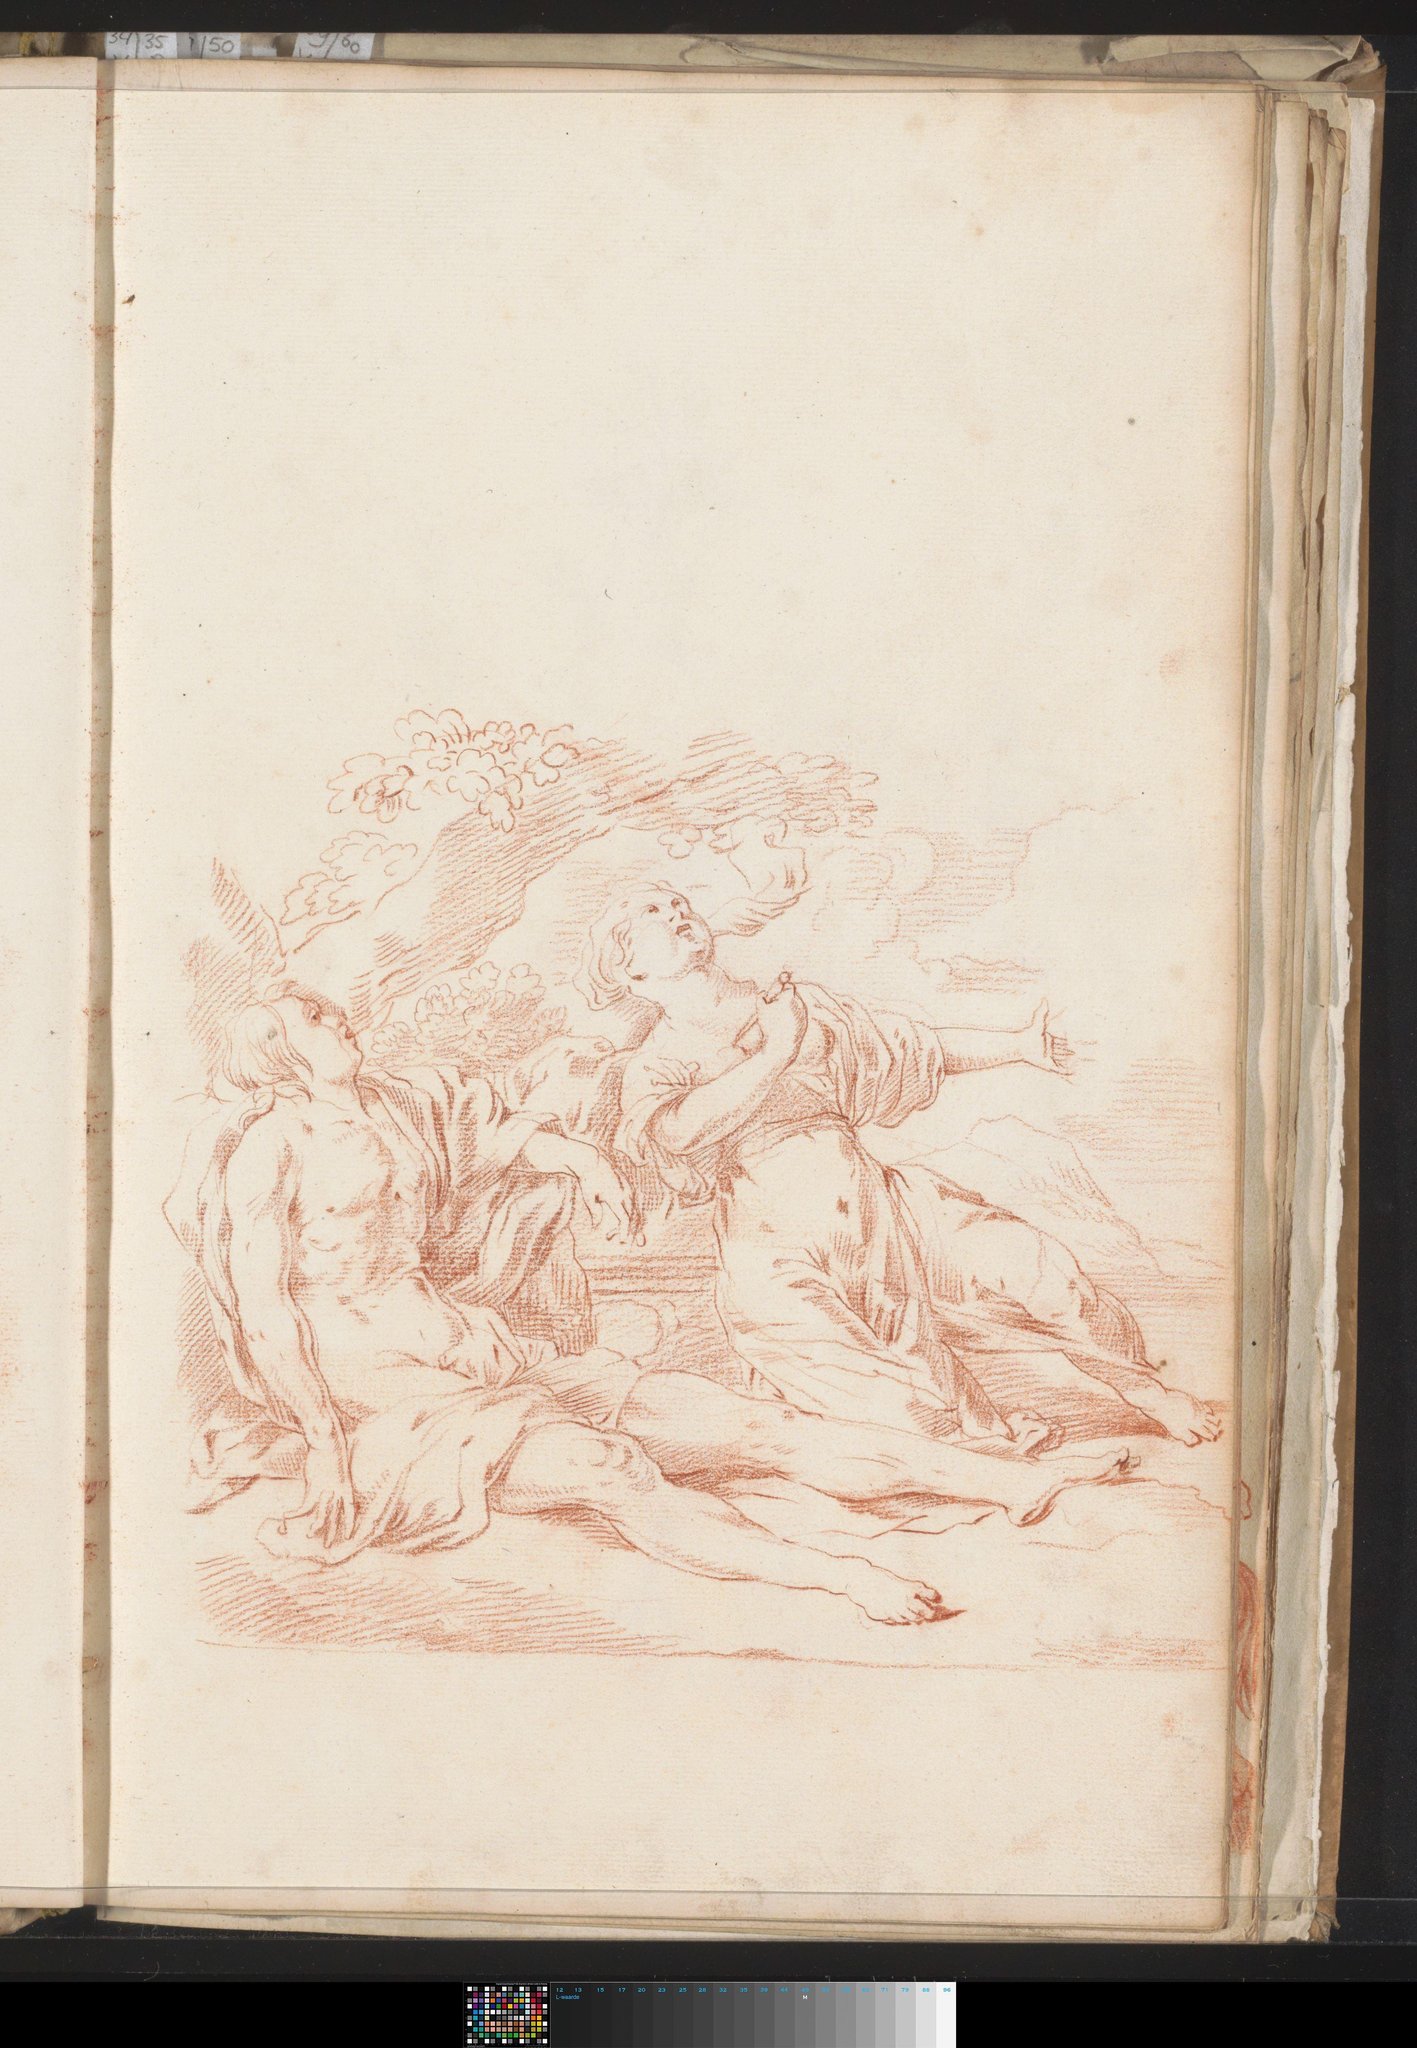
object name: sketchbook leaf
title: Dood van Lucretia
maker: jacob toorenvliet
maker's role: draughtsman, painter, print maker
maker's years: 1640-1719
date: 1701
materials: chalk, paper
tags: death of lucretia: she commits suicide by stabbing herself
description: Bij een boom in een berglandschap steekt Lucretia een dolk in haar borst. Naast haar ligt het lichaam van een halfnaakte man, mogelijk Sextus of Brutus. Blad 30 recto uit een schetsboek met 63 bladen.